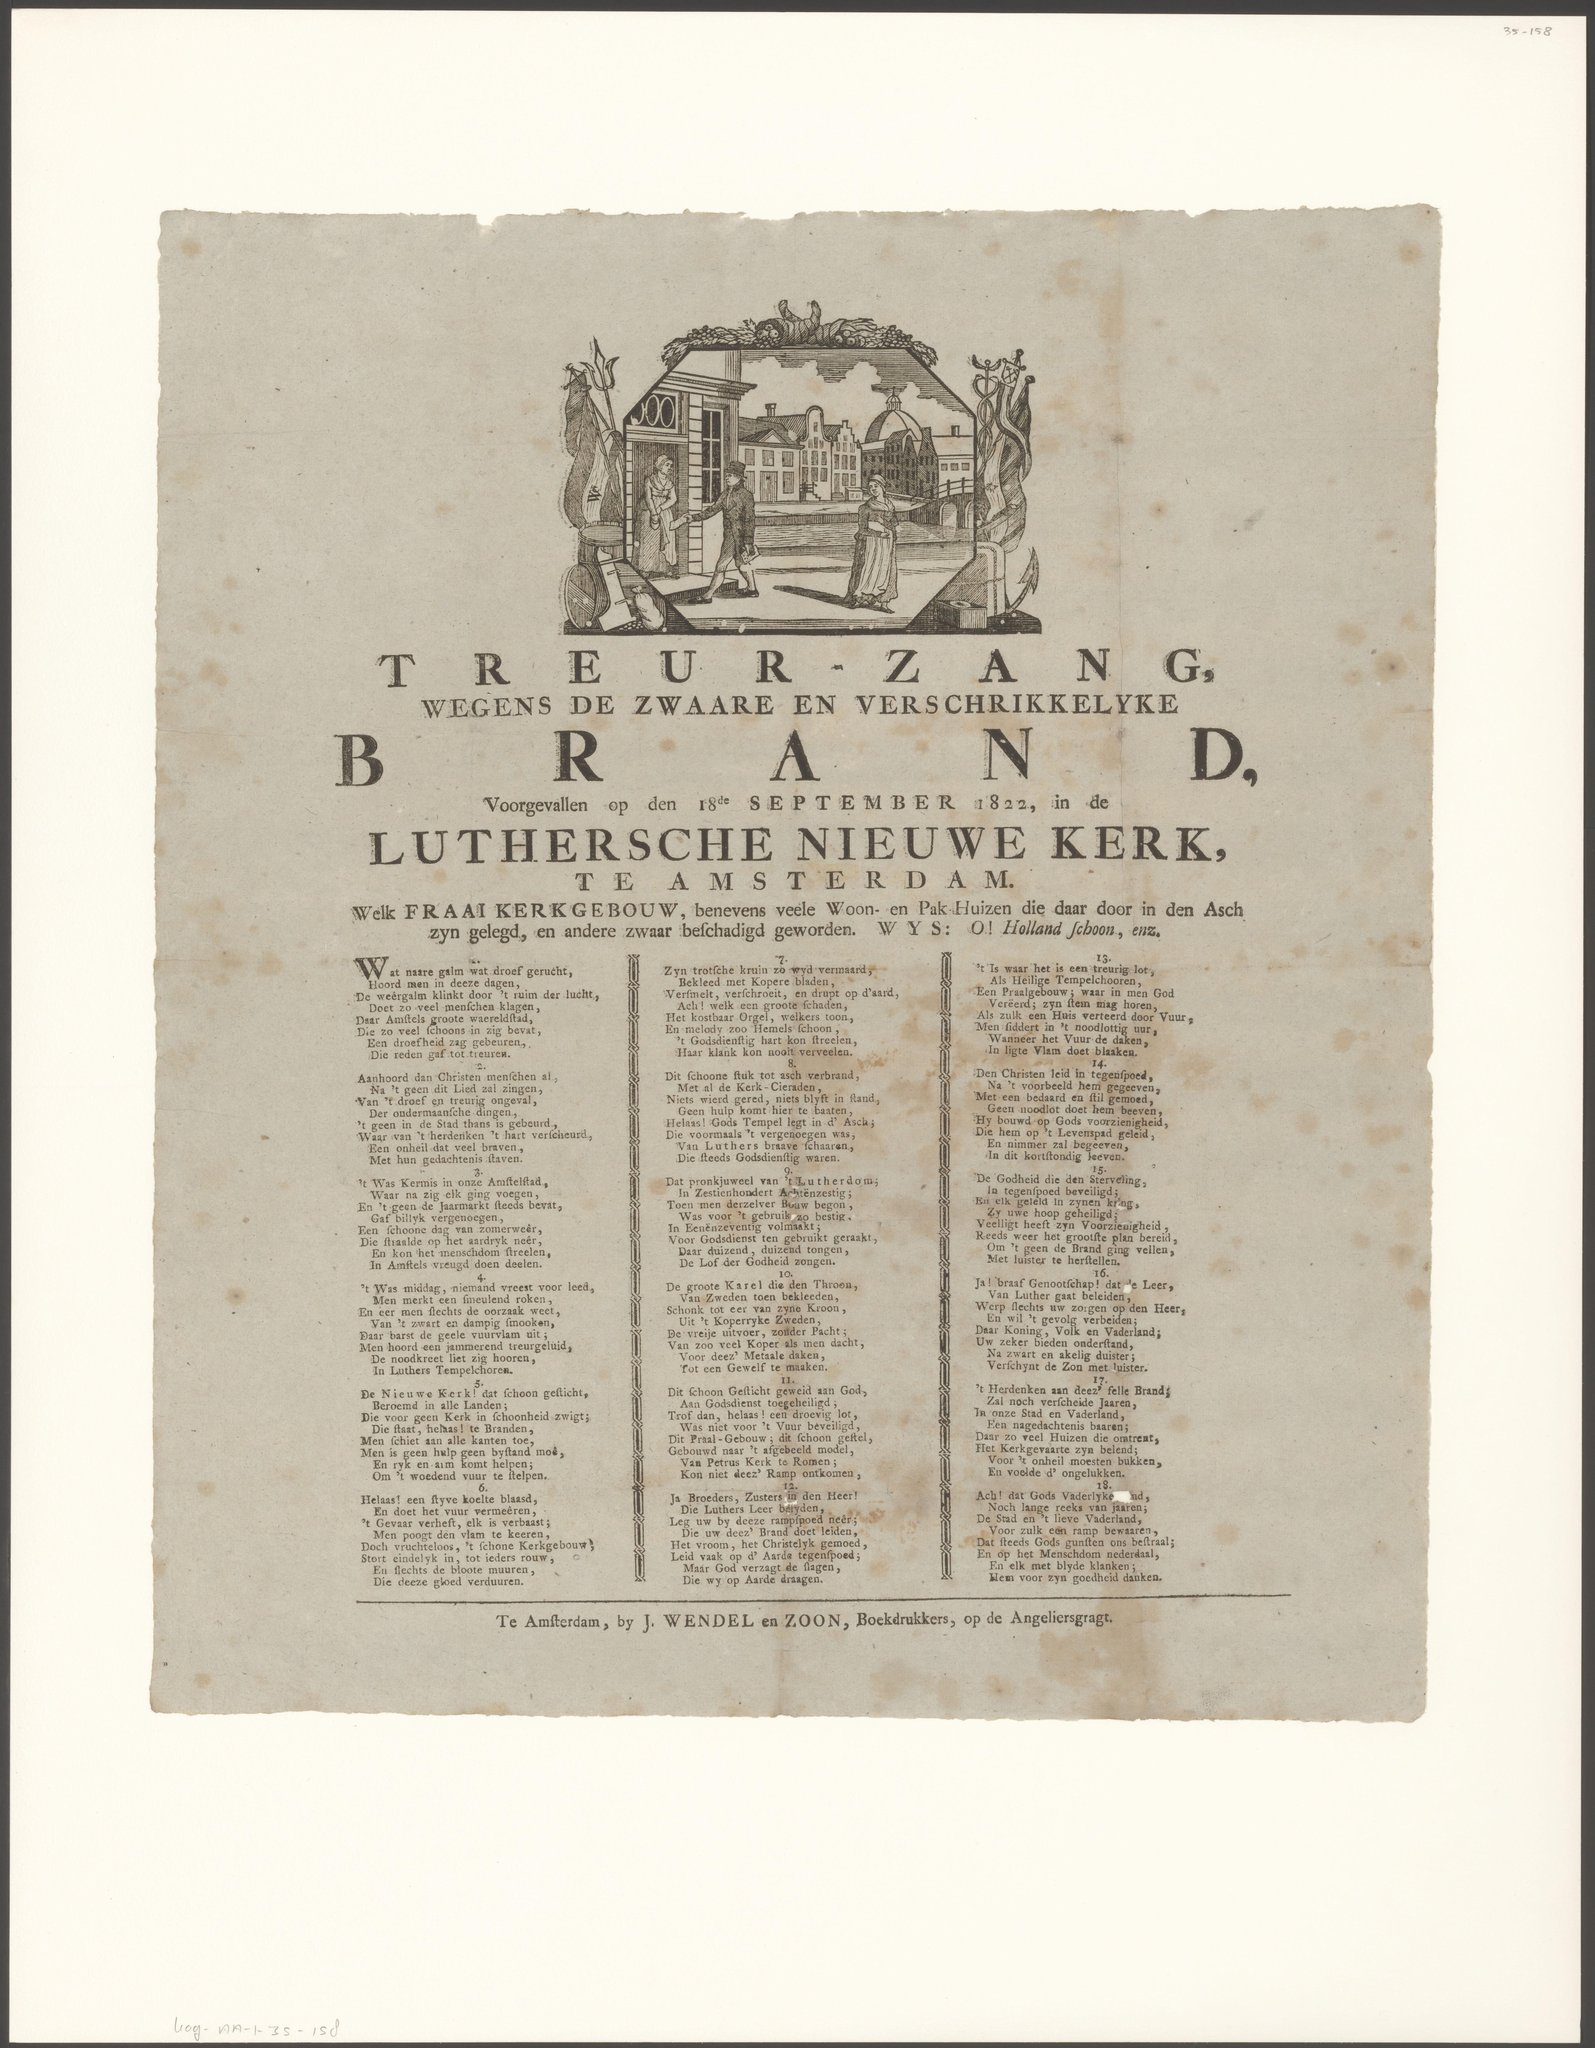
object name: print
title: Treurzang op de brand in de Nieuwe Lutherse Kerk te Amsterdam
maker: Anonymous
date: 1822-1823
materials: paper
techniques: letterpress printing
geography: amsterdam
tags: on fire, ablaze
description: Treurzang op de brand in de Nieuwe Lutherse Kerk te Amsterdam, op de wijs van: O! Holland Schoon. Bovenaan een voorstelling van een man die pamfletten uitdeelt, met op de achtergrond de koepel van de Nieuwe Lutherse Kerk. Het lied in drie kolommen. Onderwerpsrubriek binnen de Atlas Amsterdam: Kerkwezen: Ev. Lutherse Gemeente: 1822 Brand in de Nieuwe Luthersche Koepelkerk - Ruïne.